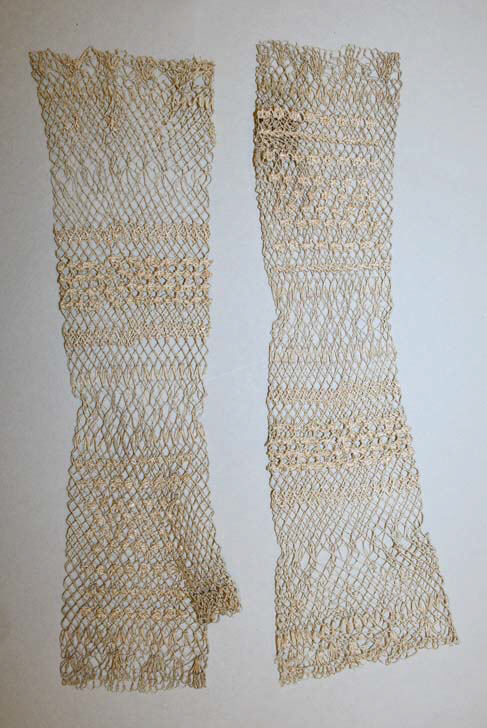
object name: mitt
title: Mitts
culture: french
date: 1882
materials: silk